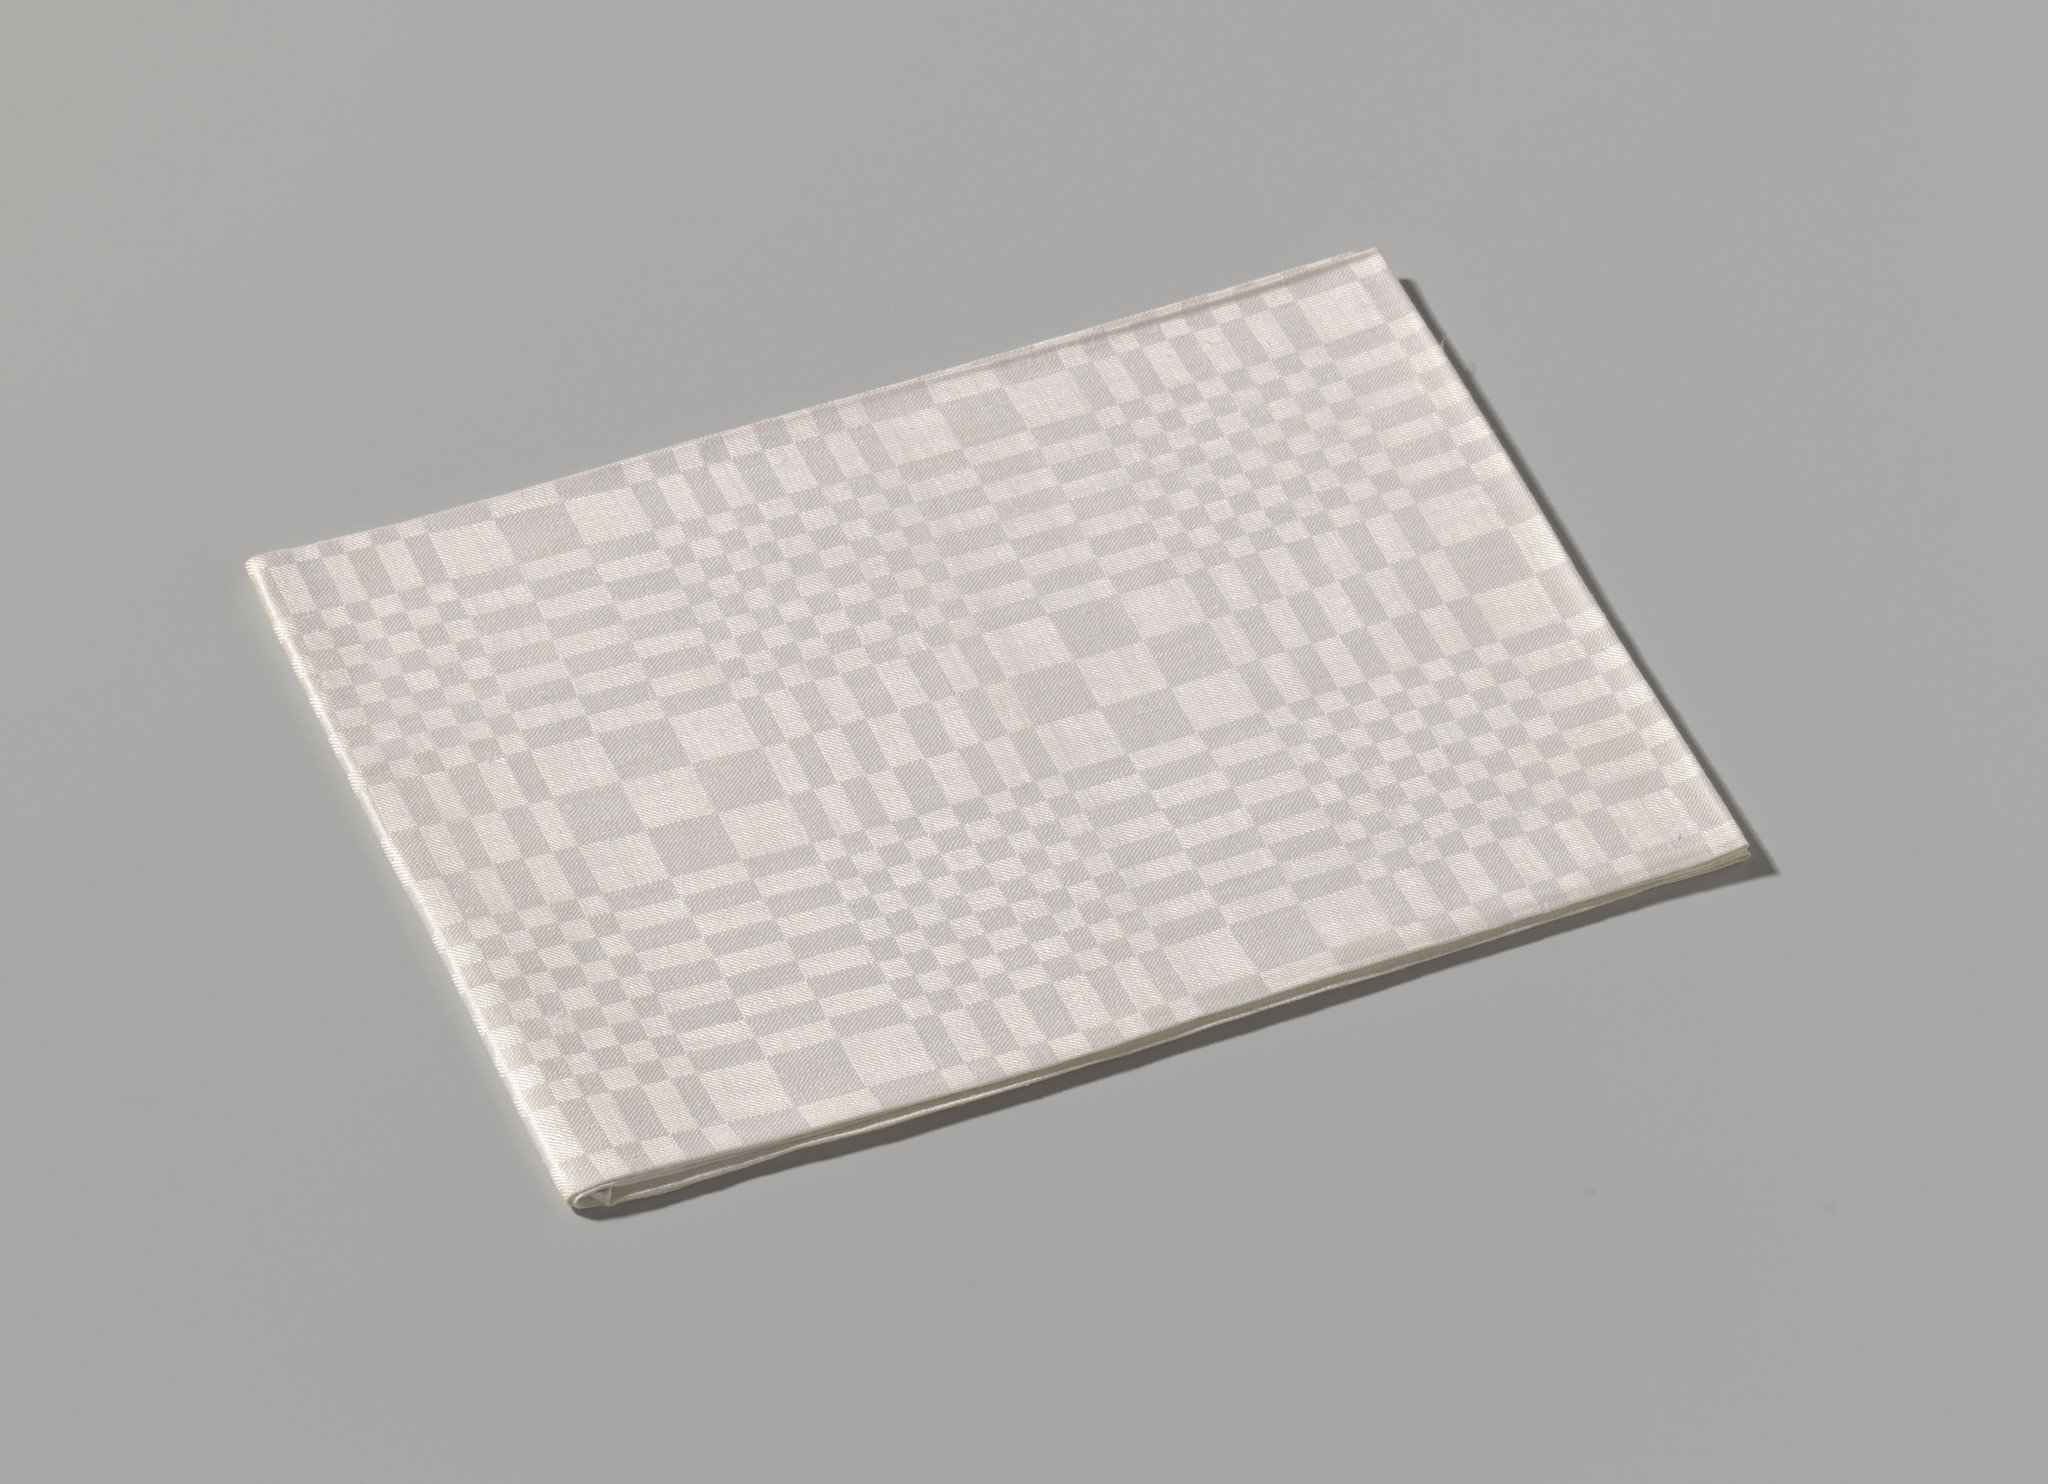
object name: napkin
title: Servet van pellendamast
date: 1739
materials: linen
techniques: weave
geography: northern netherlands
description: Wit linnen servet met pellenpatroon, genaamd "Engelse garderobe". Merk kroon WG 36 1739.